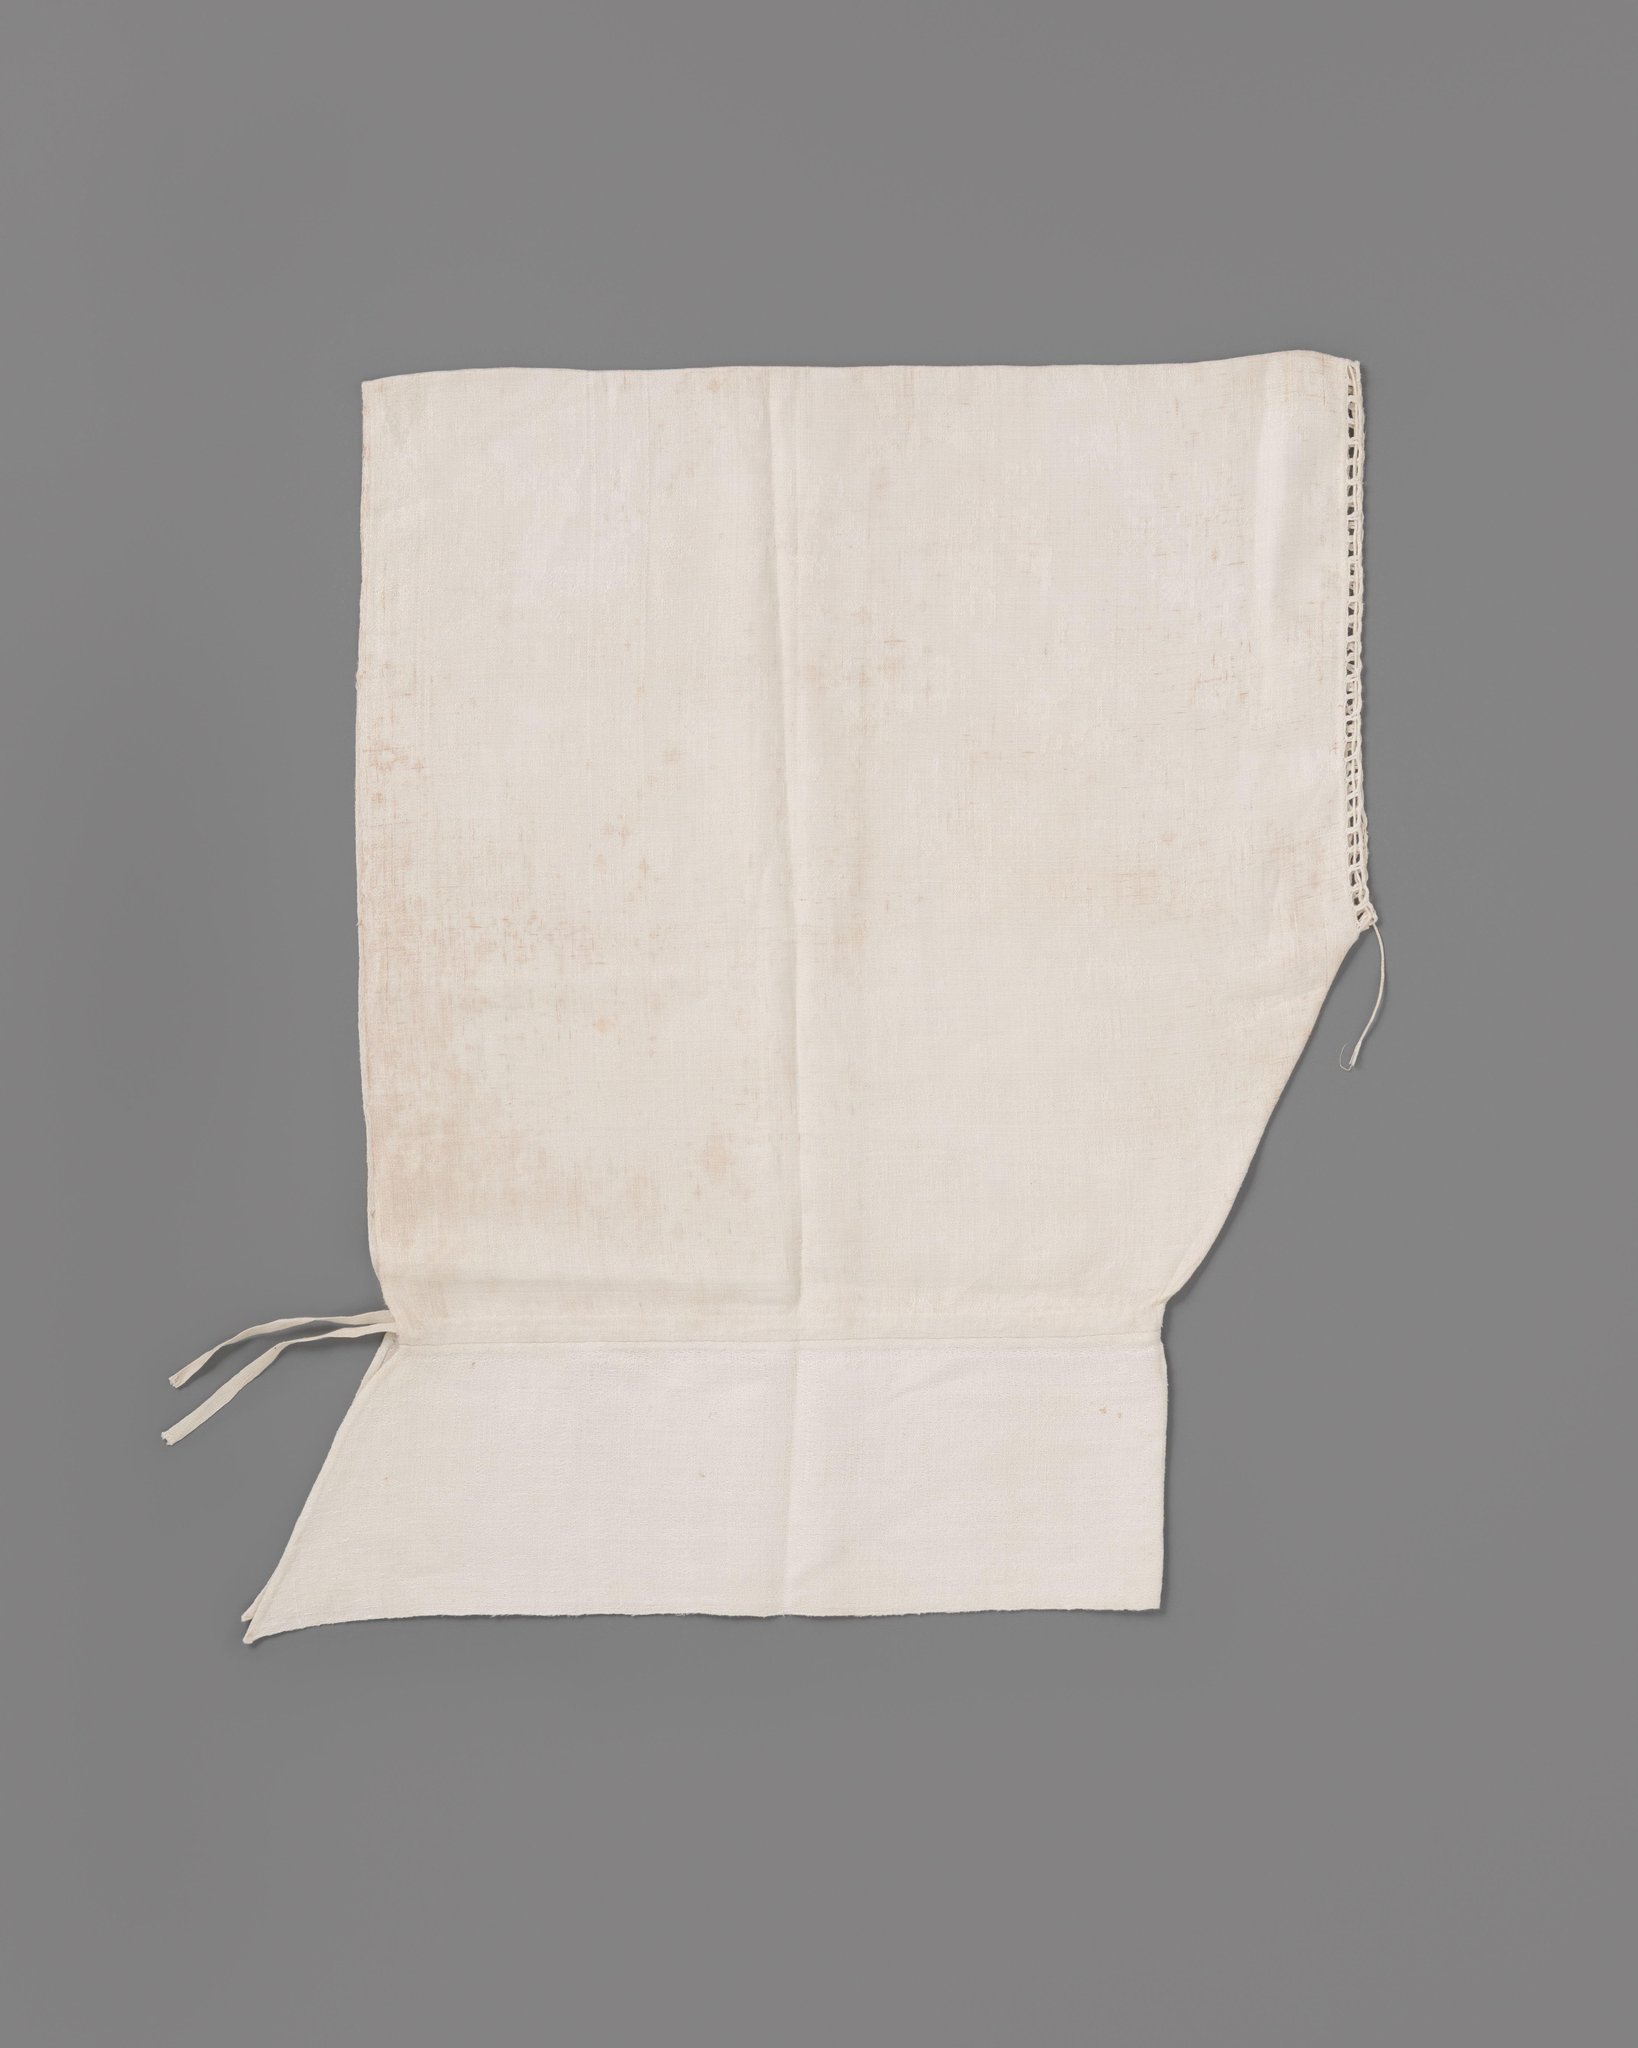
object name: cap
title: Muts of kovel, gemaakt van een servet van linnendamast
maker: Anonymous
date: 1640-1660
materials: linen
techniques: cross stitching, damask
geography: netherlands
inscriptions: initials: ‘ZW// 6’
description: Muts of kovel van linnendamast. De muts heeft op de kruin een tunnel waar een koord doorheen is geregen. Ook rond de hals is een tunnel waar een koord doorheen is geregen. De muts is gemaakt van een servet. De muts is gemerkt in kruissteek: ZW/ 6.